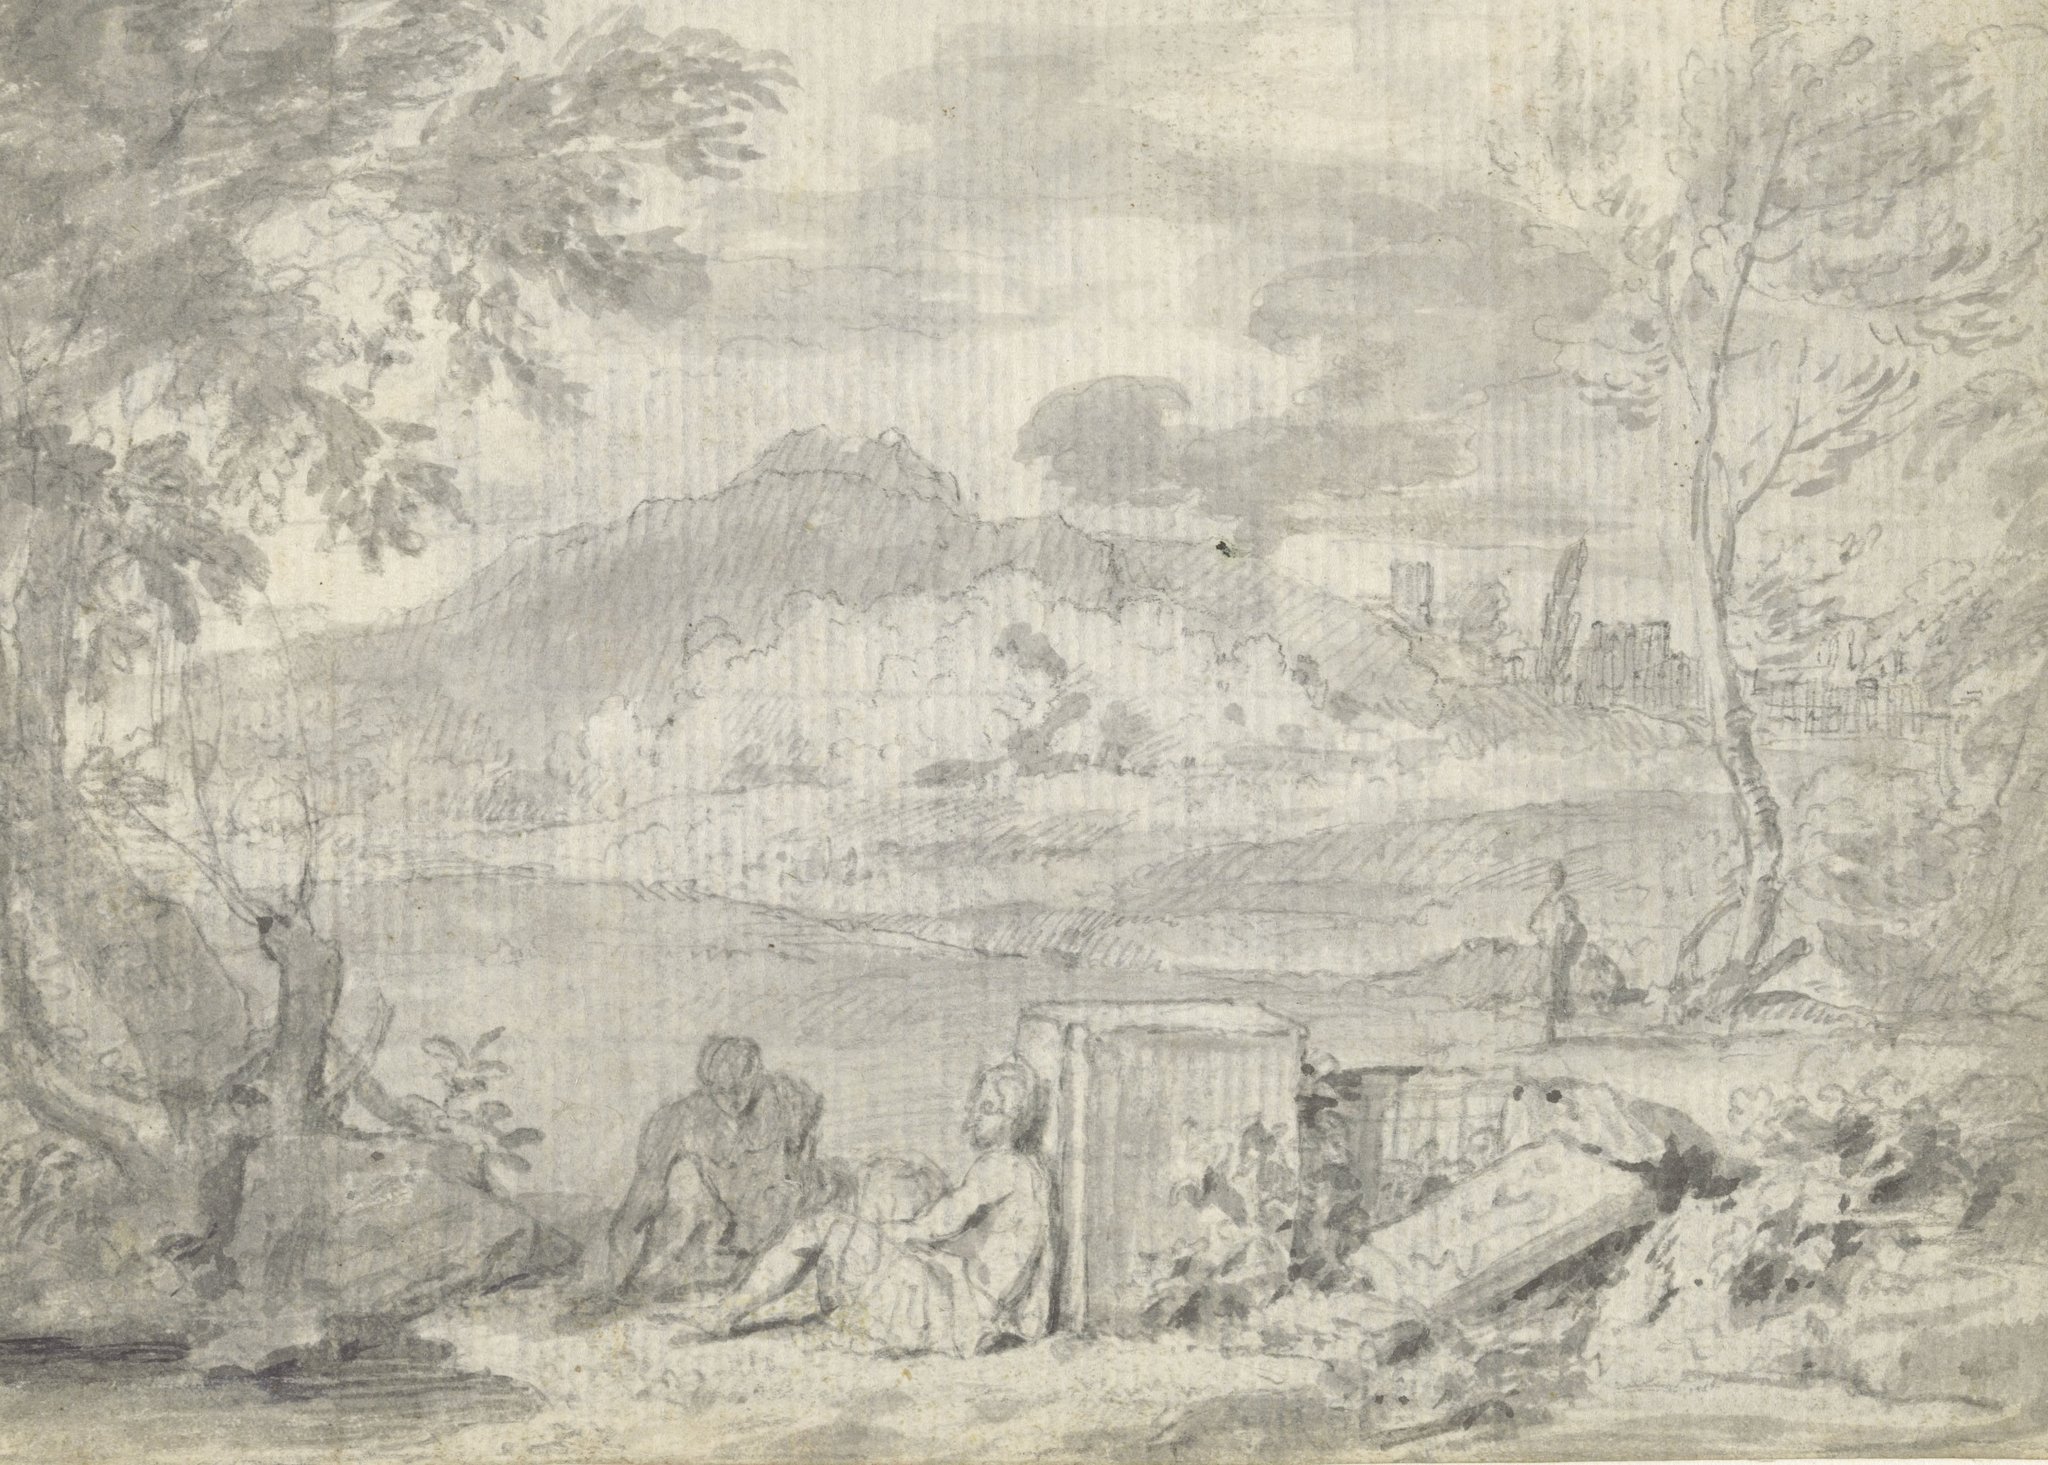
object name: drawing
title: Landschap met vierkante steen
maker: abraham genoels (ii)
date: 1686-1688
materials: chalk, paper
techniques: brush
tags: landscapes in the temperate zone